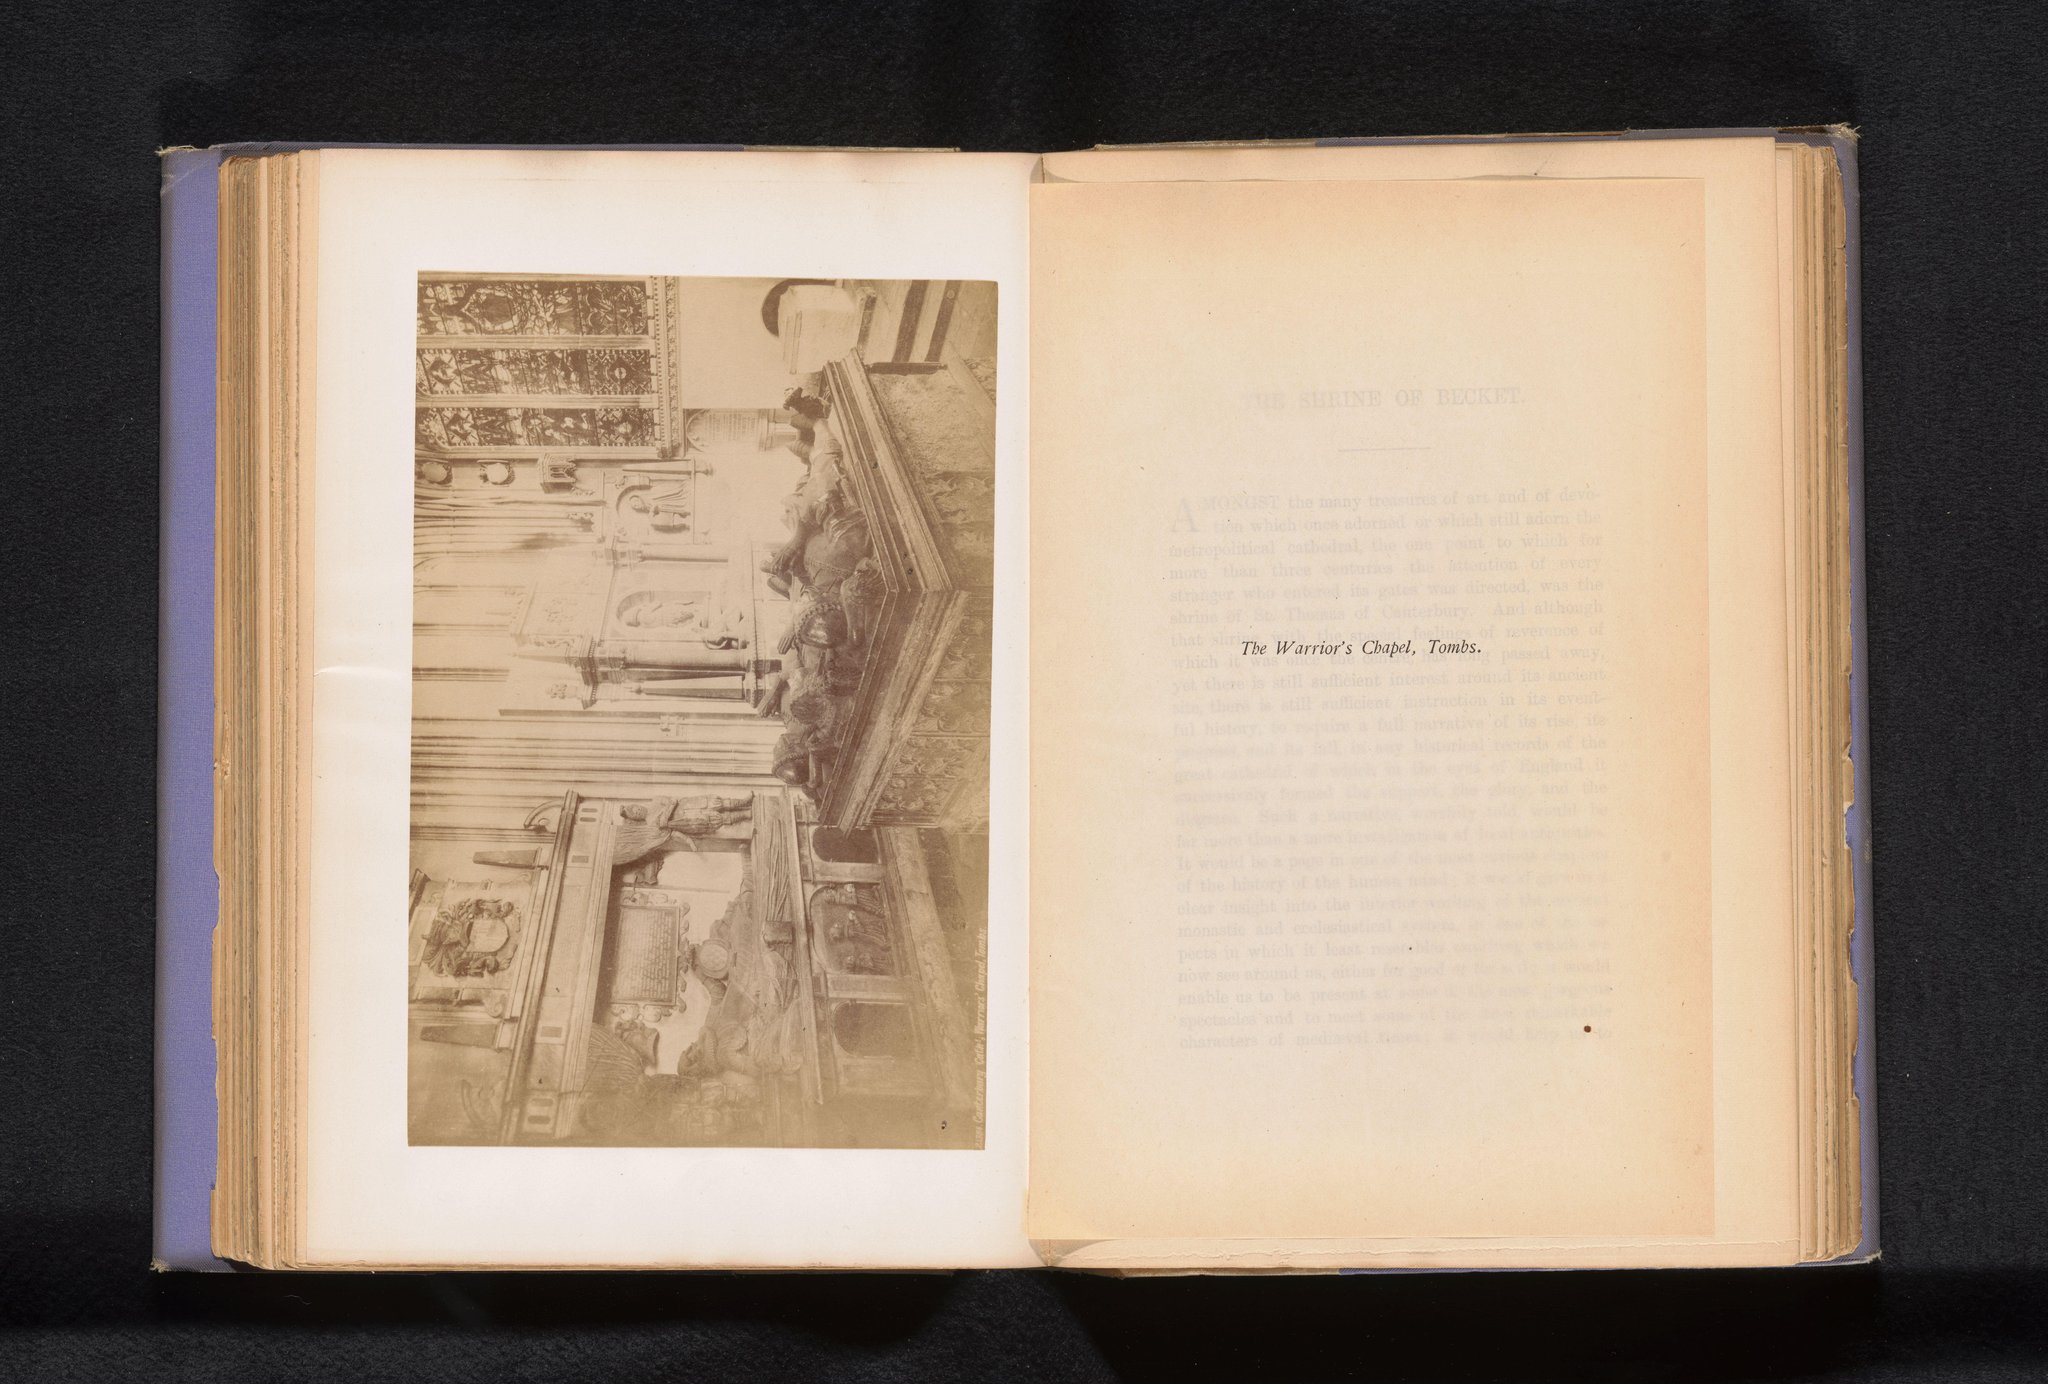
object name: photograph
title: The Warrior's Chapel, Tombs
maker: Anonymous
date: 1882-1892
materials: photographic support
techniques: albumen print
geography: canterbury cathedral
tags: grave, tomb, parts of church interior: chapel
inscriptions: number: ‘21384. Canterbury Cath. Warrior's Chapel, Tombs.’